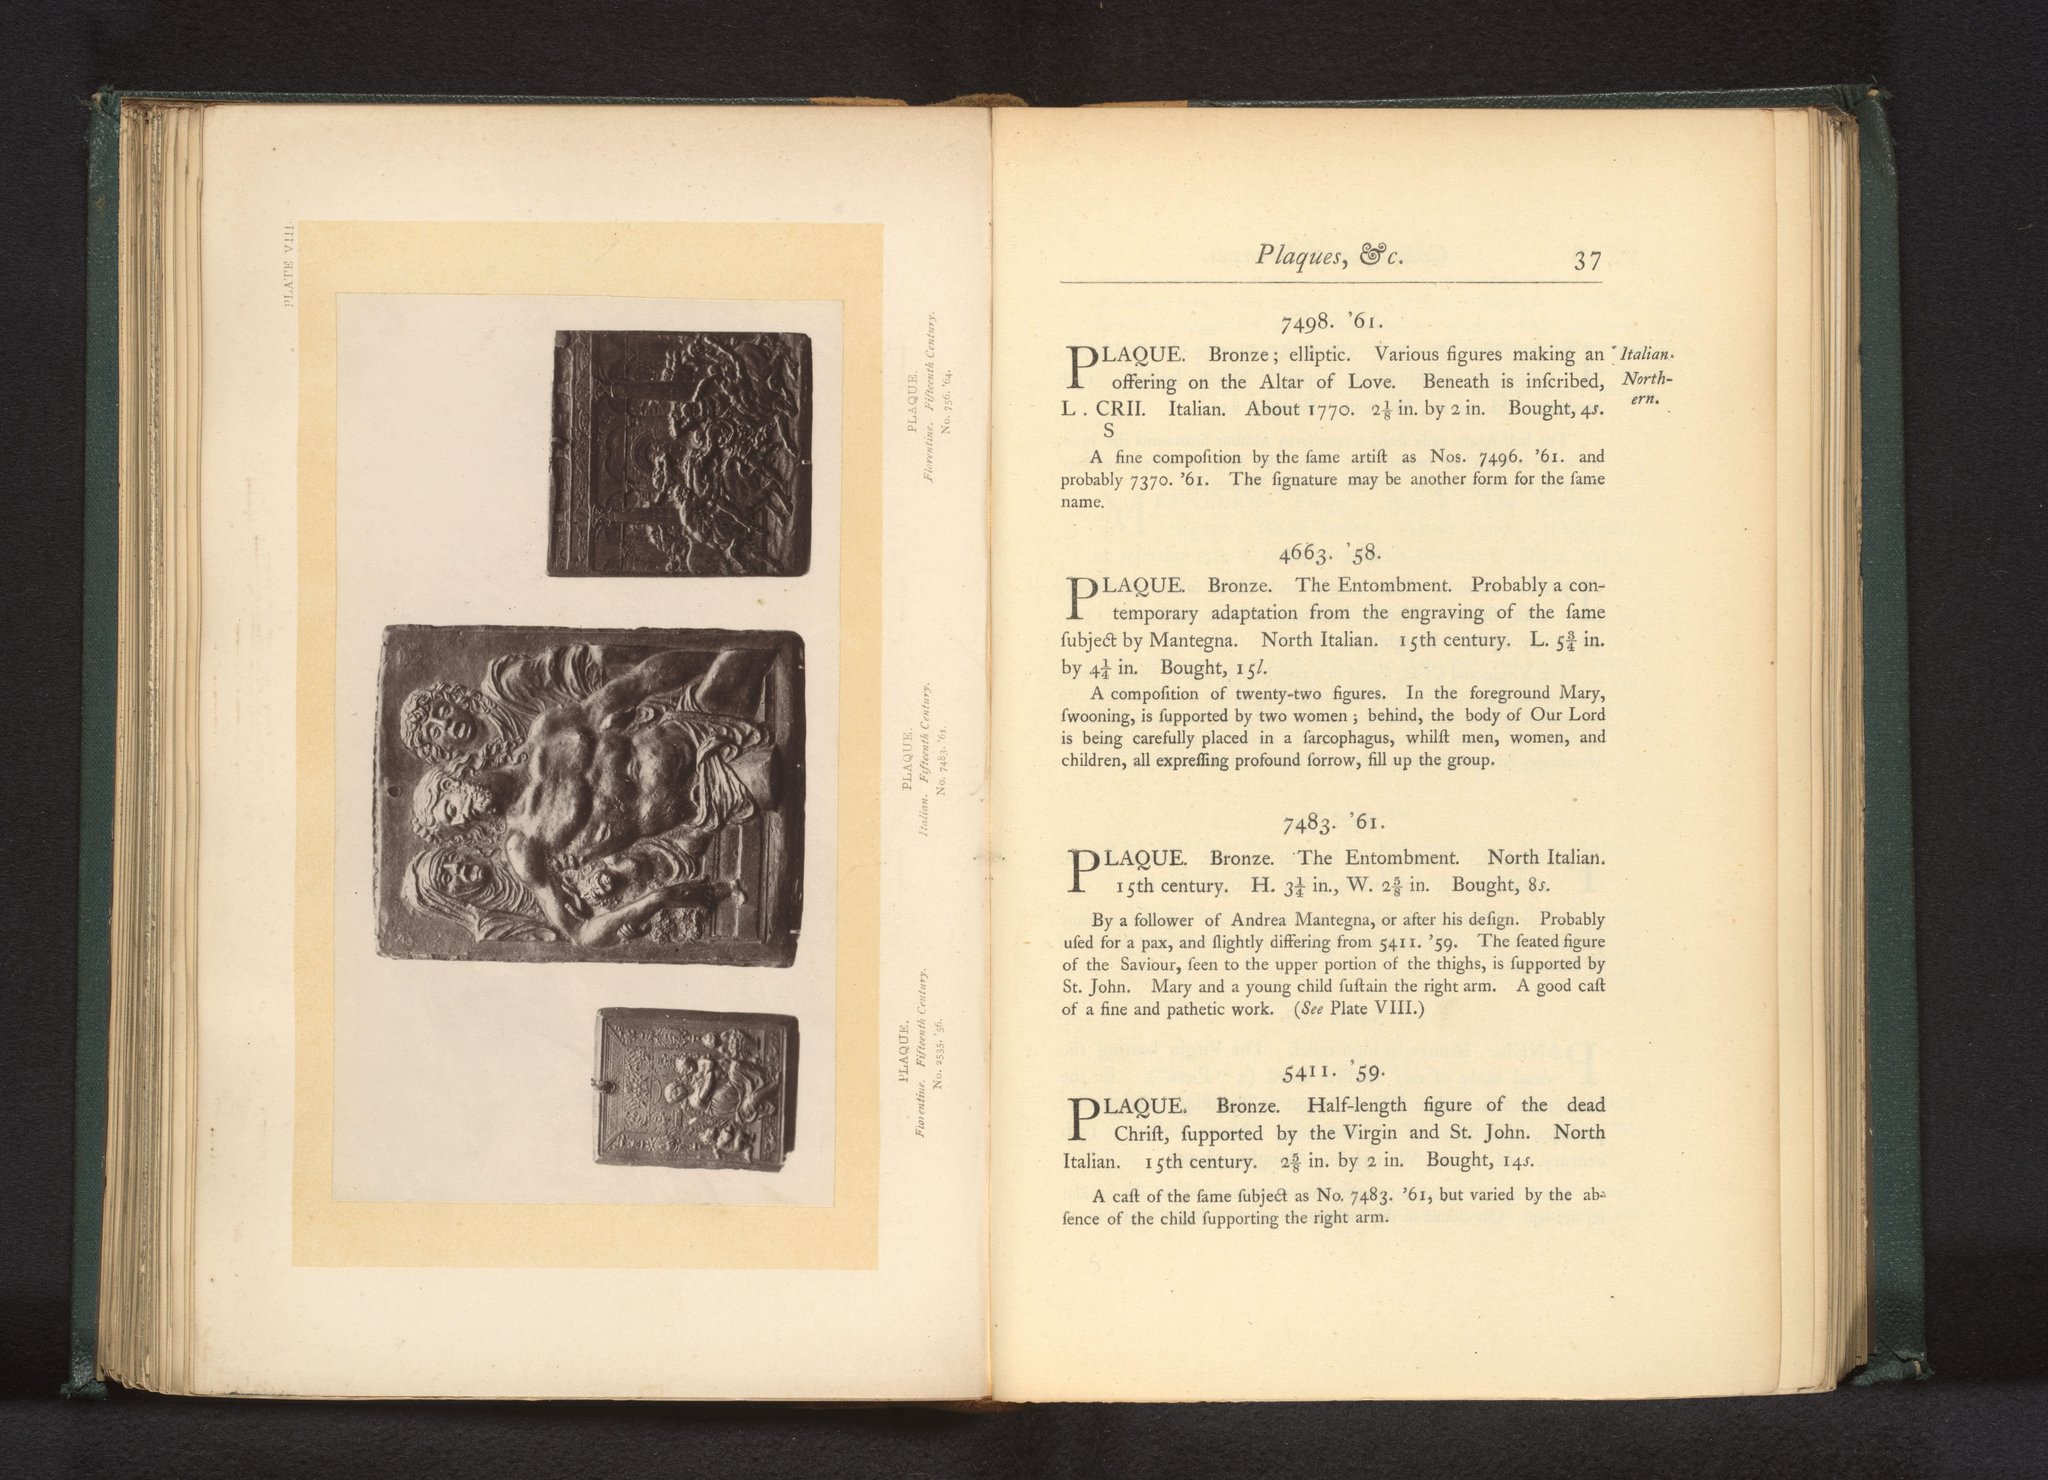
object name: page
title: Drie bronzen plakkaten met reliëfs in het South Kensington Museum te Londen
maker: Anonymous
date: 1869-1876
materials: paper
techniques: woodburytype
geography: london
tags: seal (as symbol of the state, etc.), sculpture (+ relief ~ sculpture)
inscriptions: number: ‘No. 2535. '56 (...) No. 756. '64.’, inscription: ‘Plaque (...) plaque.’, number: ‘Plate VIII.’